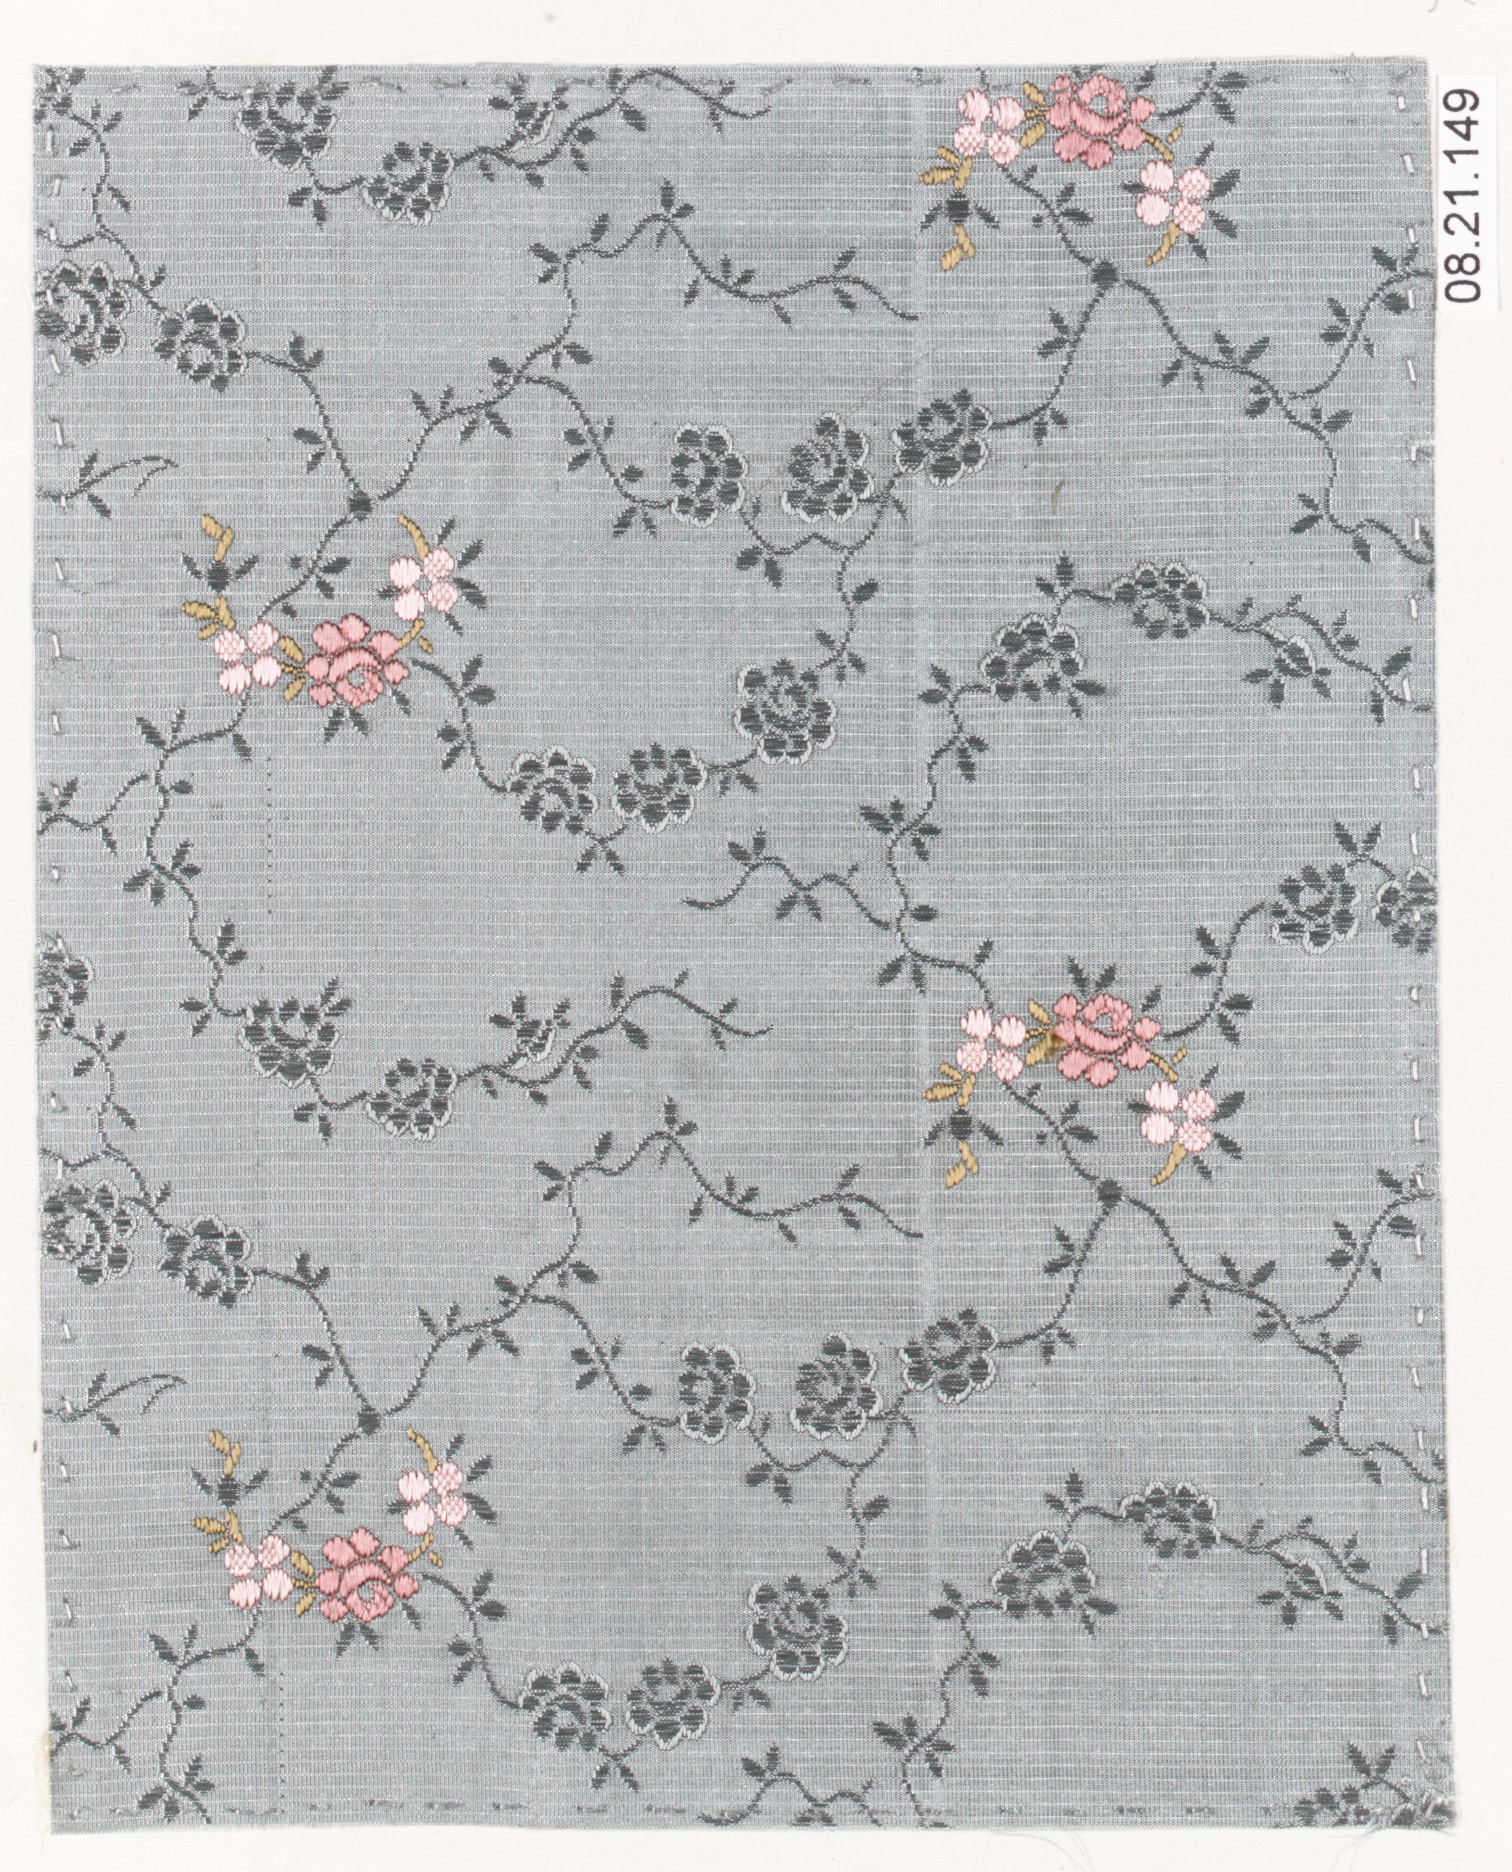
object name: textile sample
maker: Anonymous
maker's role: designer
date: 1900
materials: silk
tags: flowers